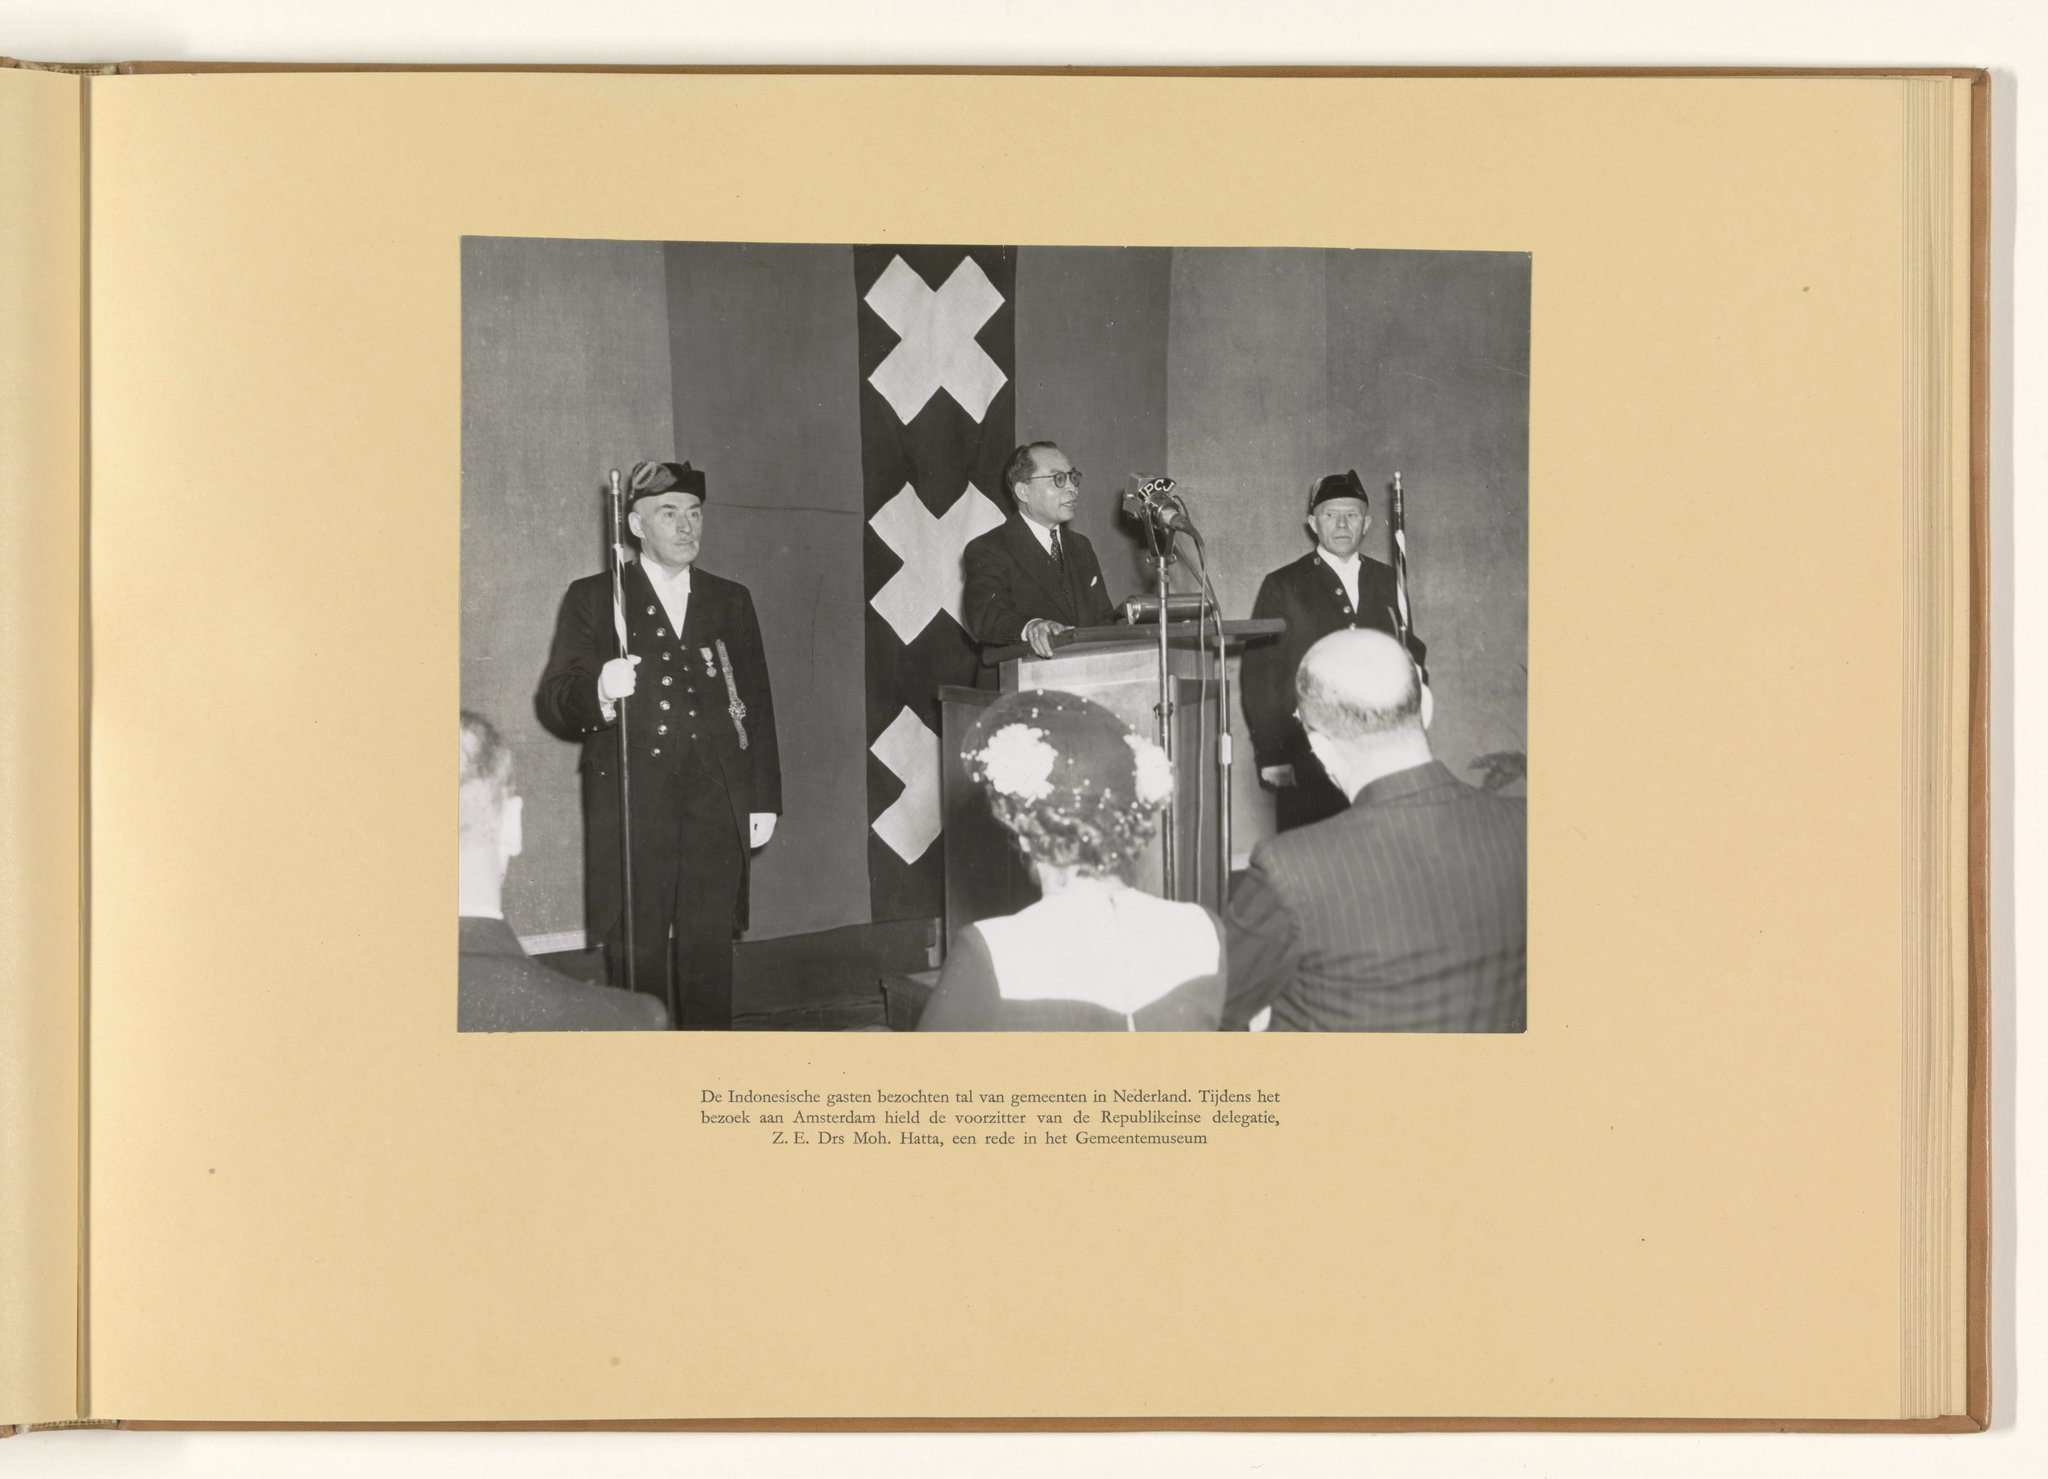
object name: photograph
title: De Indonesische gasten bezochten tal van gemeenten in Nederland. Tijdens het bezoek aan Amsterdam hield de voorzitter van de Republikeinse delegatie, Z.E. Drs Moh. Hatta, een rede in het Gemeentemuseum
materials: paper, photographic support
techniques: gelatin silver print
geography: amsterdam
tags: mohammad hatta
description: Premier Mohammed Hatta spreekt in het Amsterdamse Gemeentemuseum (= Stedelijk Museum). Foto in het fotoalbum met 37 foto's van de rondetafelconferentie gehouden tussen 23 augustus en 2 november in Den Haag in 1949 tussen vertegenwoordigers van Nederland, de Republiek Indonesië en de Bijeenkomst Federaal Overleg. Het exemplaar aangeboden aan premier Willem Drees.